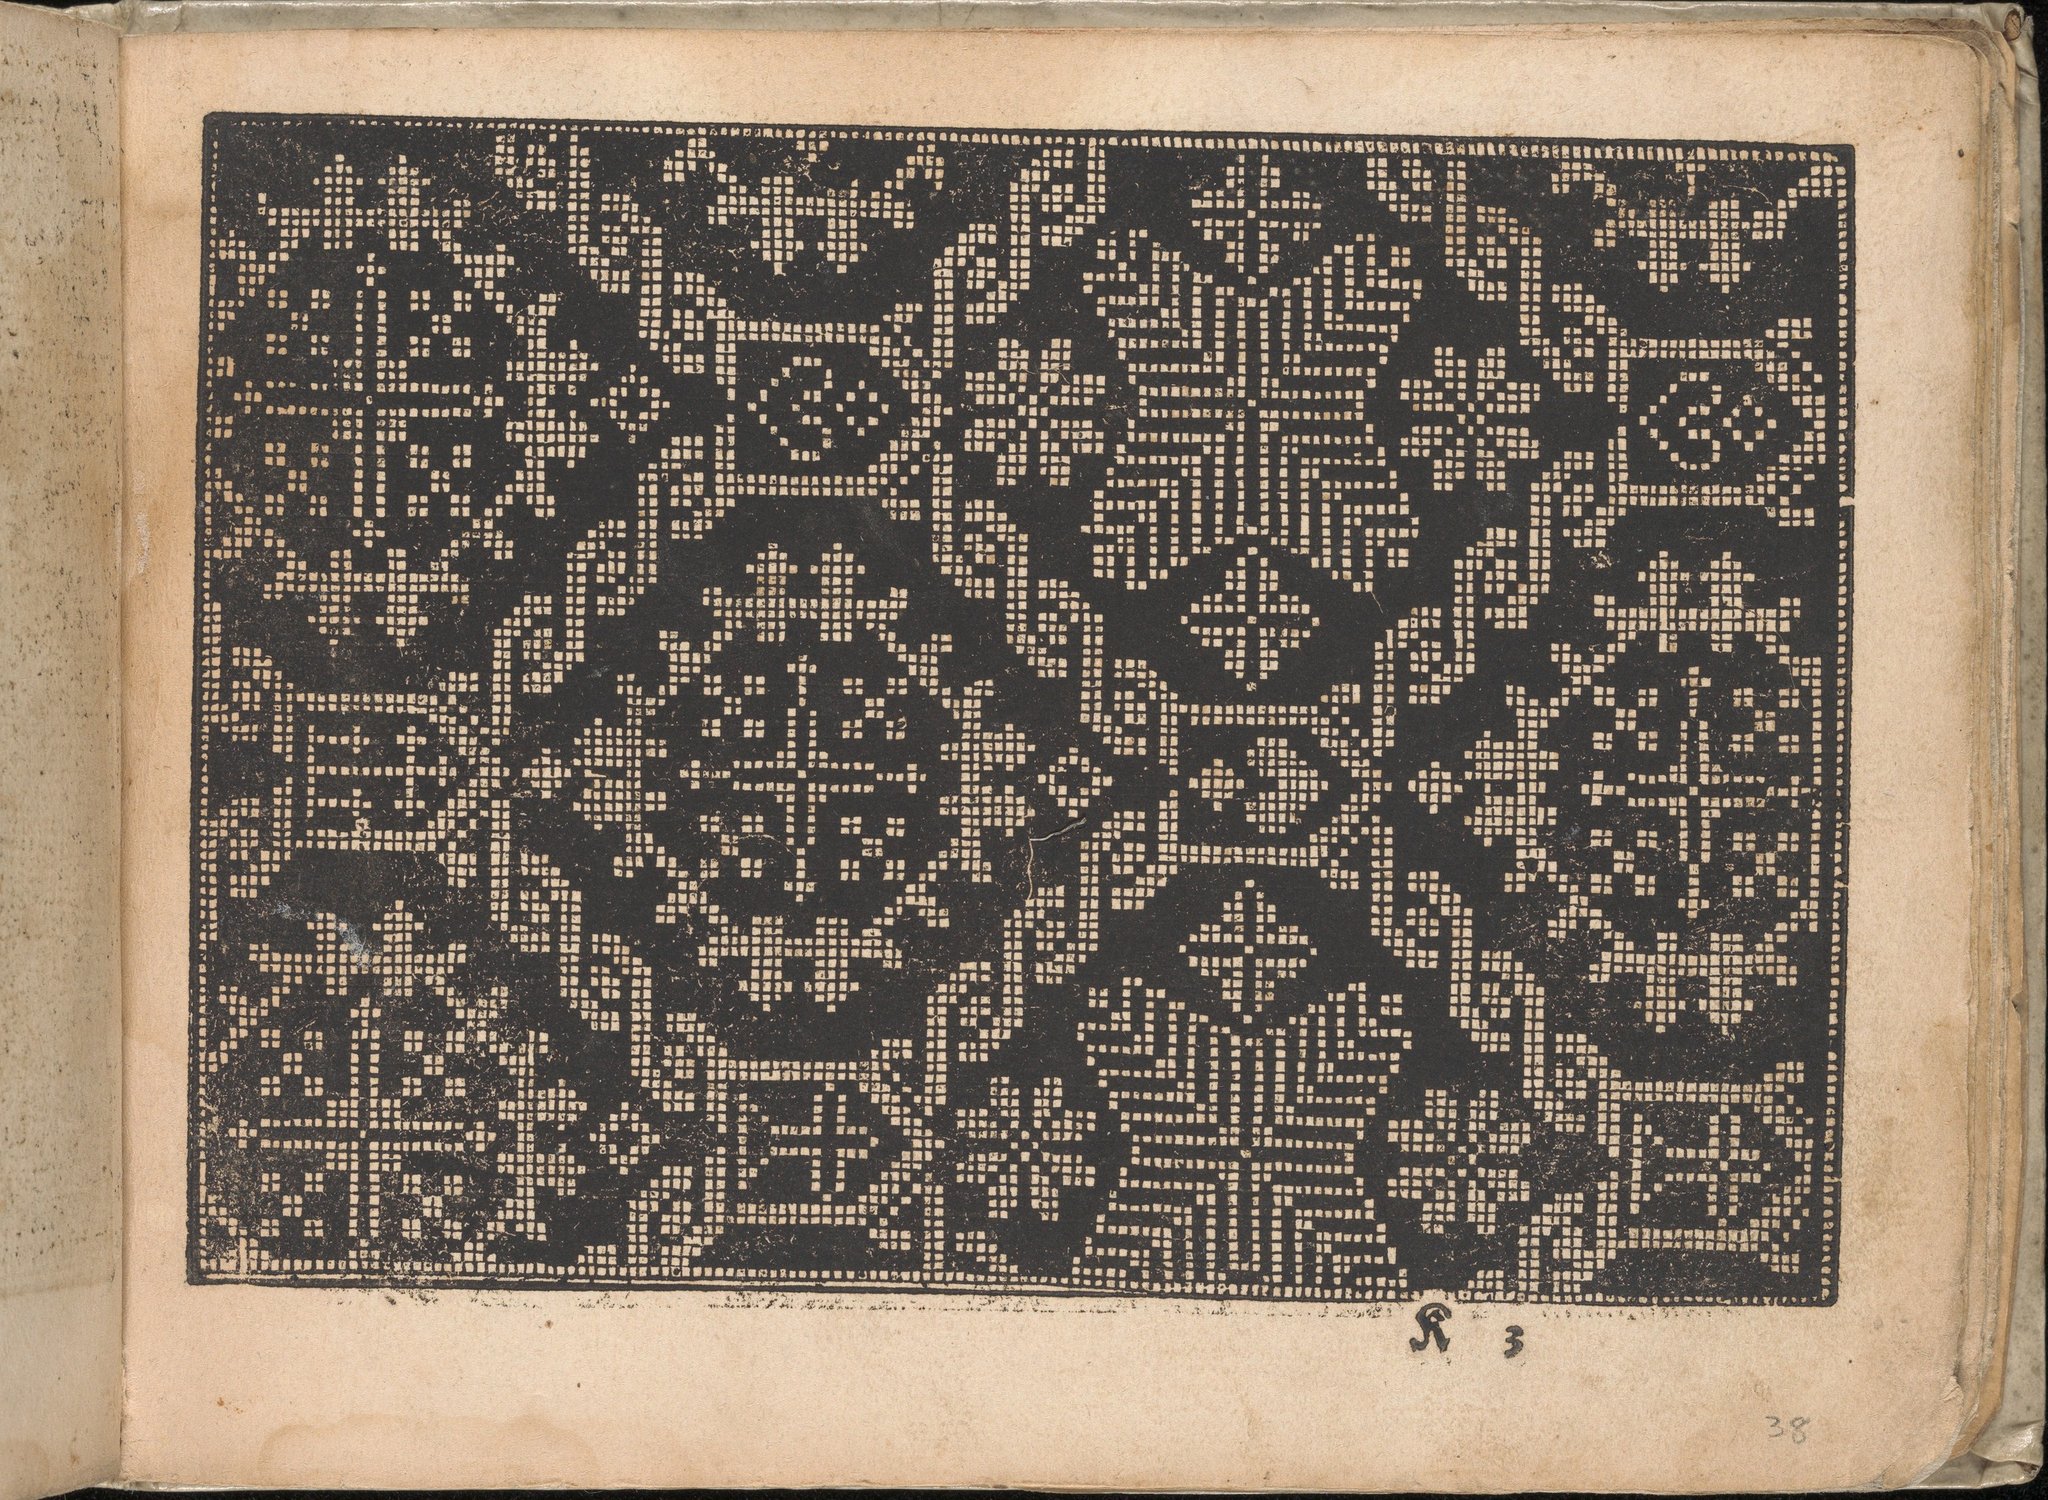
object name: ornament architecture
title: Neu künstlich Modelbuch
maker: bernhard jobin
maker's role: publisher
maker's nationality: swiss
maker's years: 1535-1597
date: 1598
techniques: woodcut